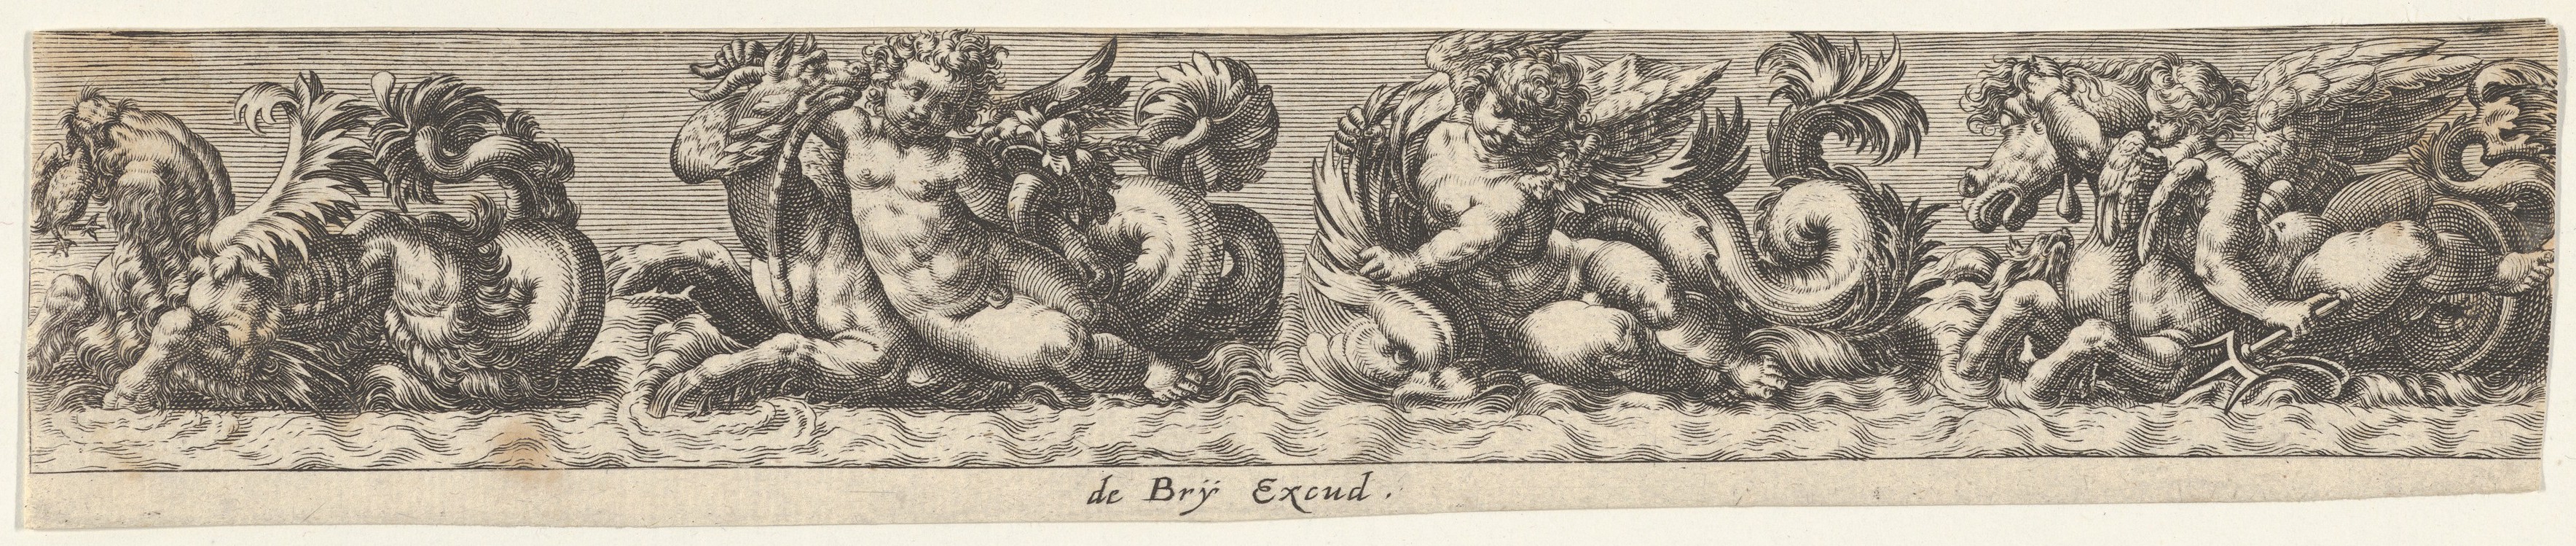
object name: print ornament architecture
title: Frieze with Sea Monsters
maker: johann theodor de bry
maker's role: artist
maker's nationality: netherlandish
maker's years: 1561-1623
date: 1580-1600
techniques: engraving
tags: mythical creatures,putti